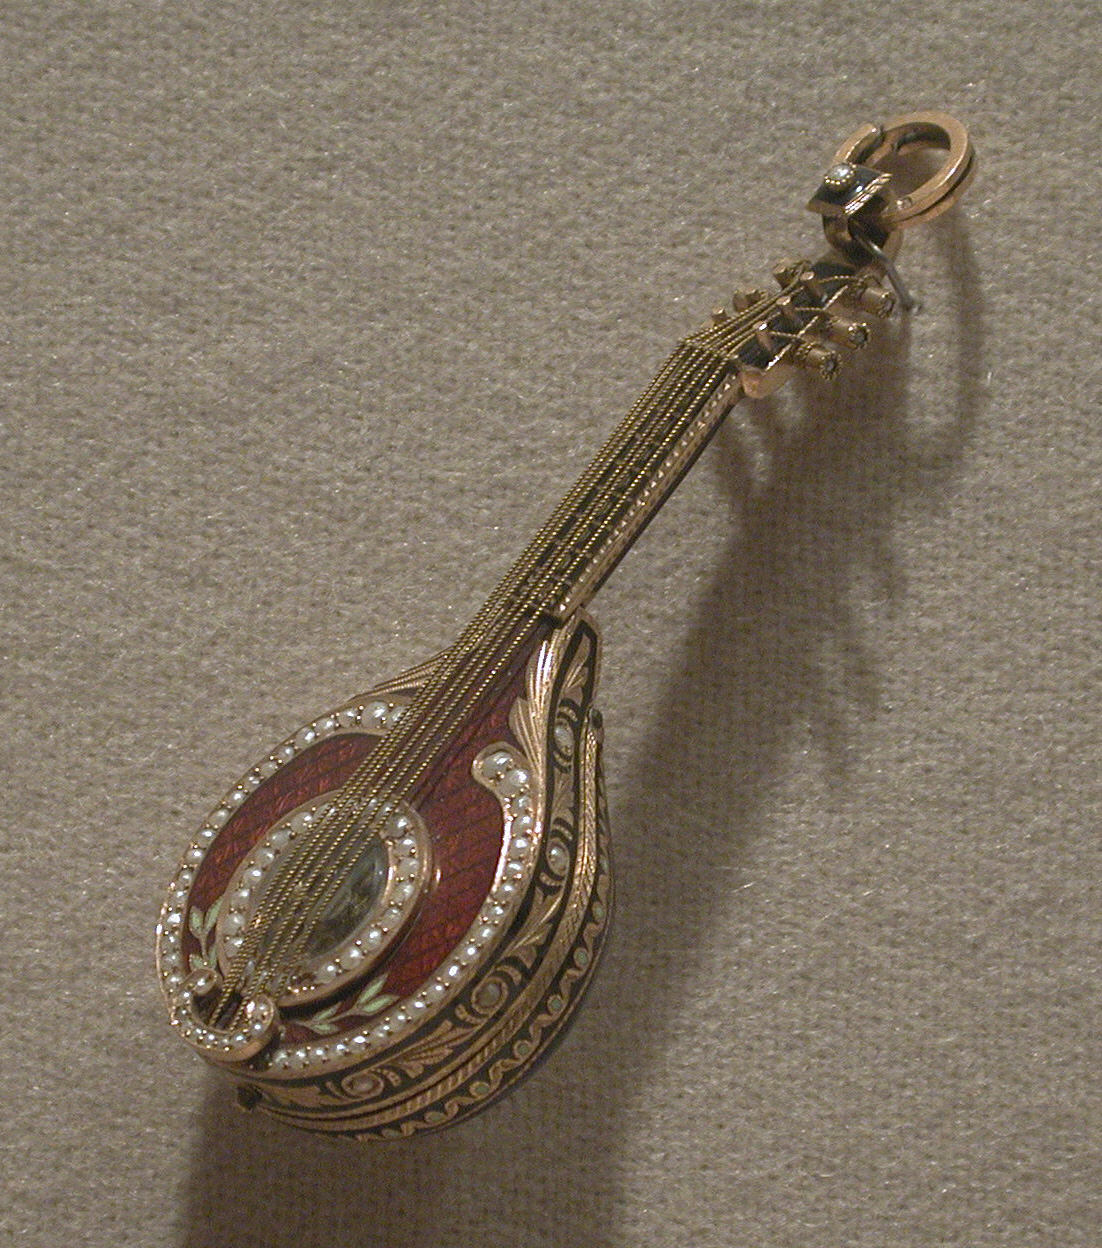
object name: watch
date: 1801-1900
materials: enamel, gold, pearl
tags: musical instruments